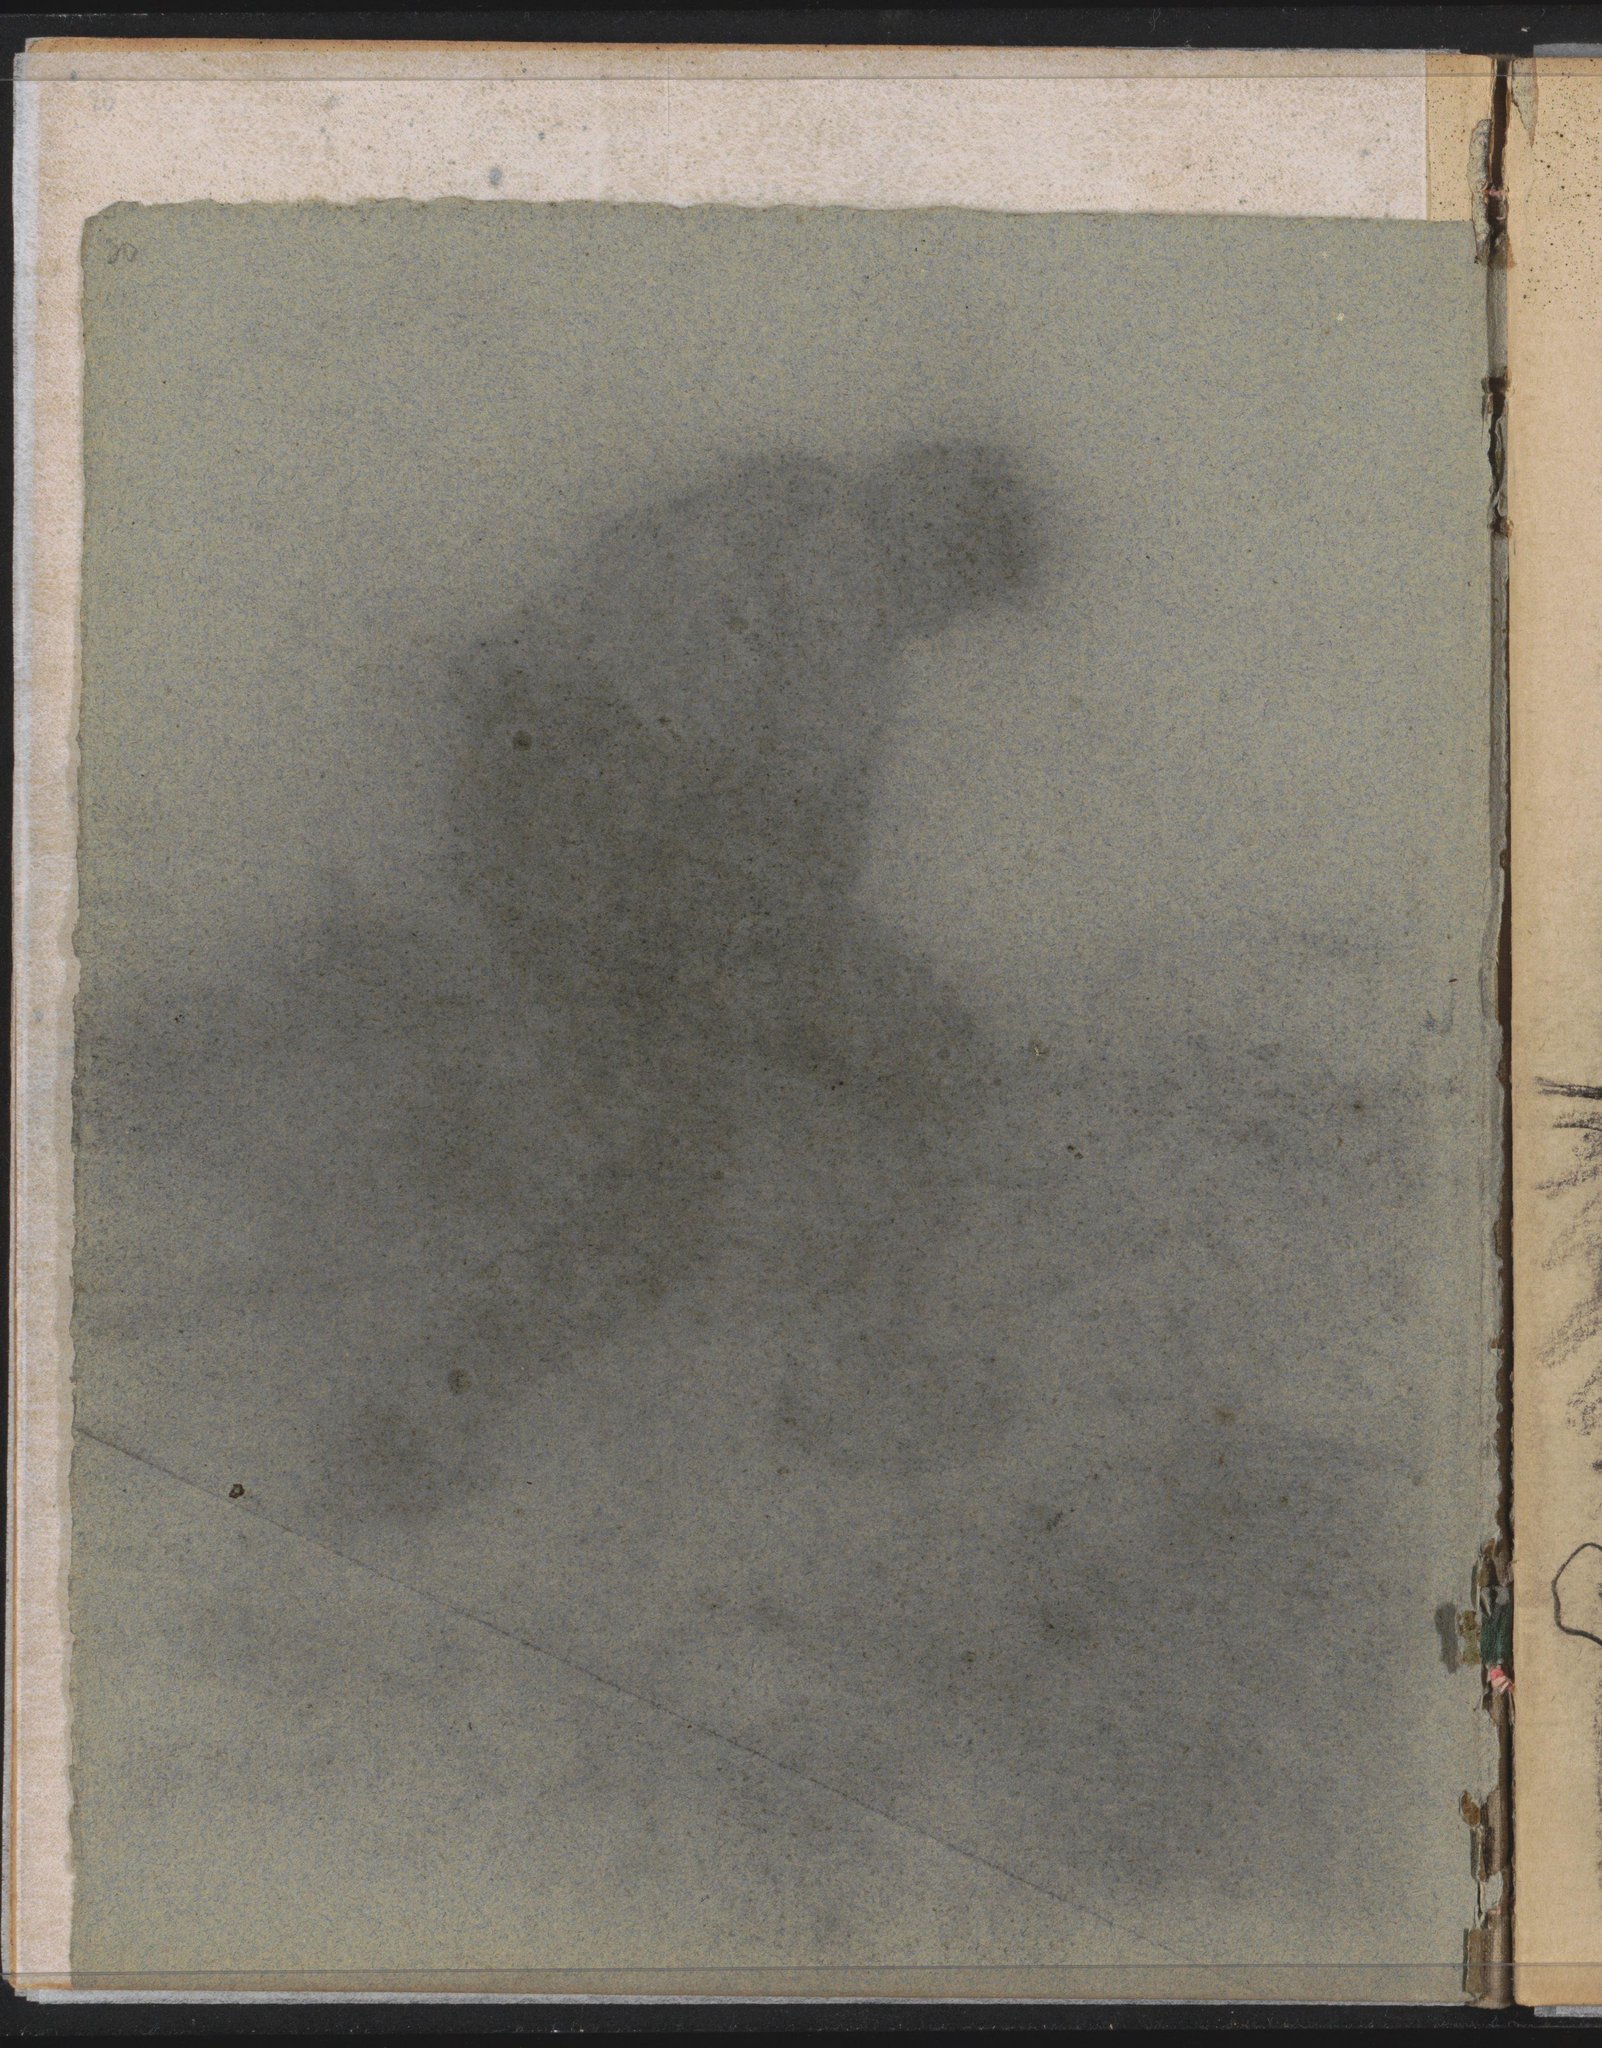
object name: sketchbook leaf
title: Abklatsch van de krijttekening op pagina 31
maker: willem witsen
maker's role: draughtsman, painter, print maker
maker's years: 1860-1923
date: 1884-1891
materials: paper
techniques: printmaking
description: Pagina 30 uit een schetsboek met 49 bladen.